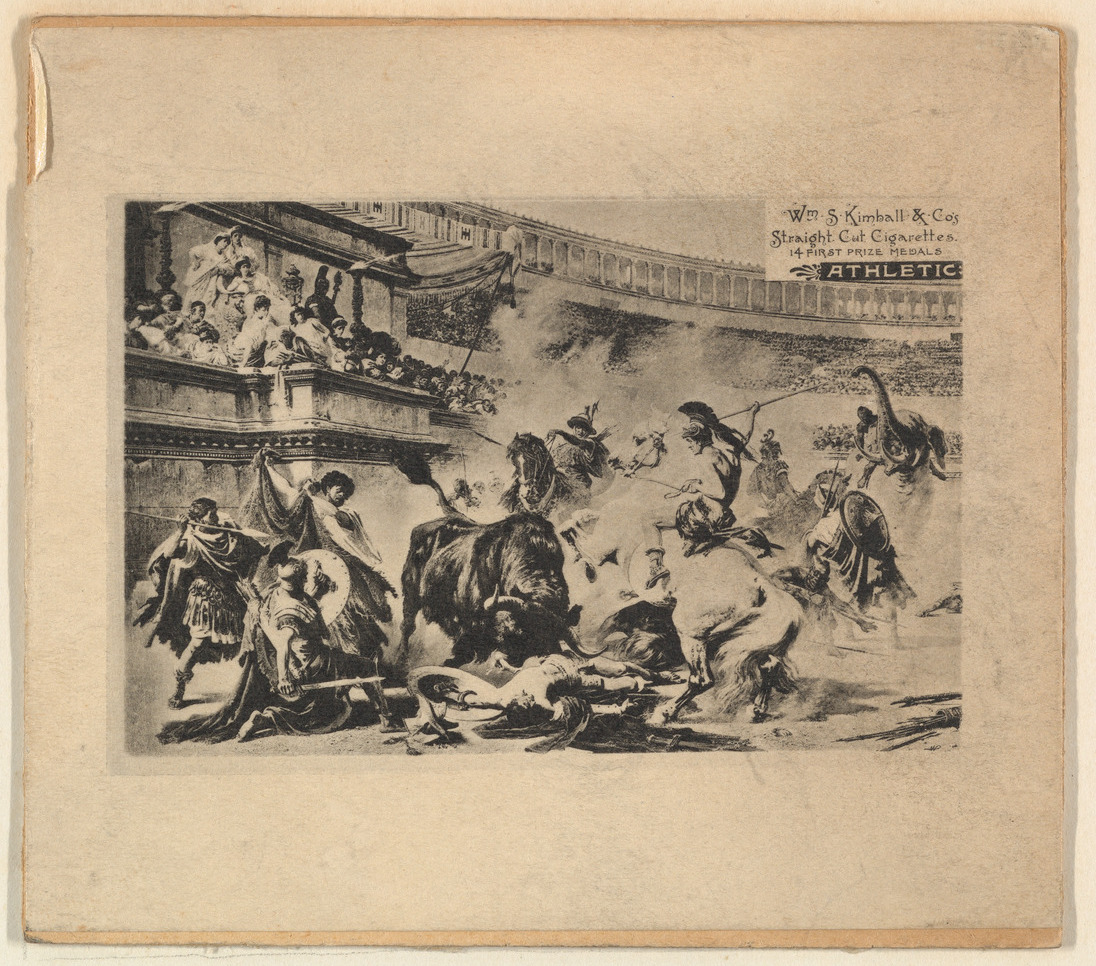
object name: print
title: Athletic, from the Sports and Art Subjects series (N197) issued by Wm. S. Kimball & Co.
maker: william s. kimball & company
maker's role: publisher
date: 1889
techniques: color lithograph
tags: men,spectators,bulls,horses